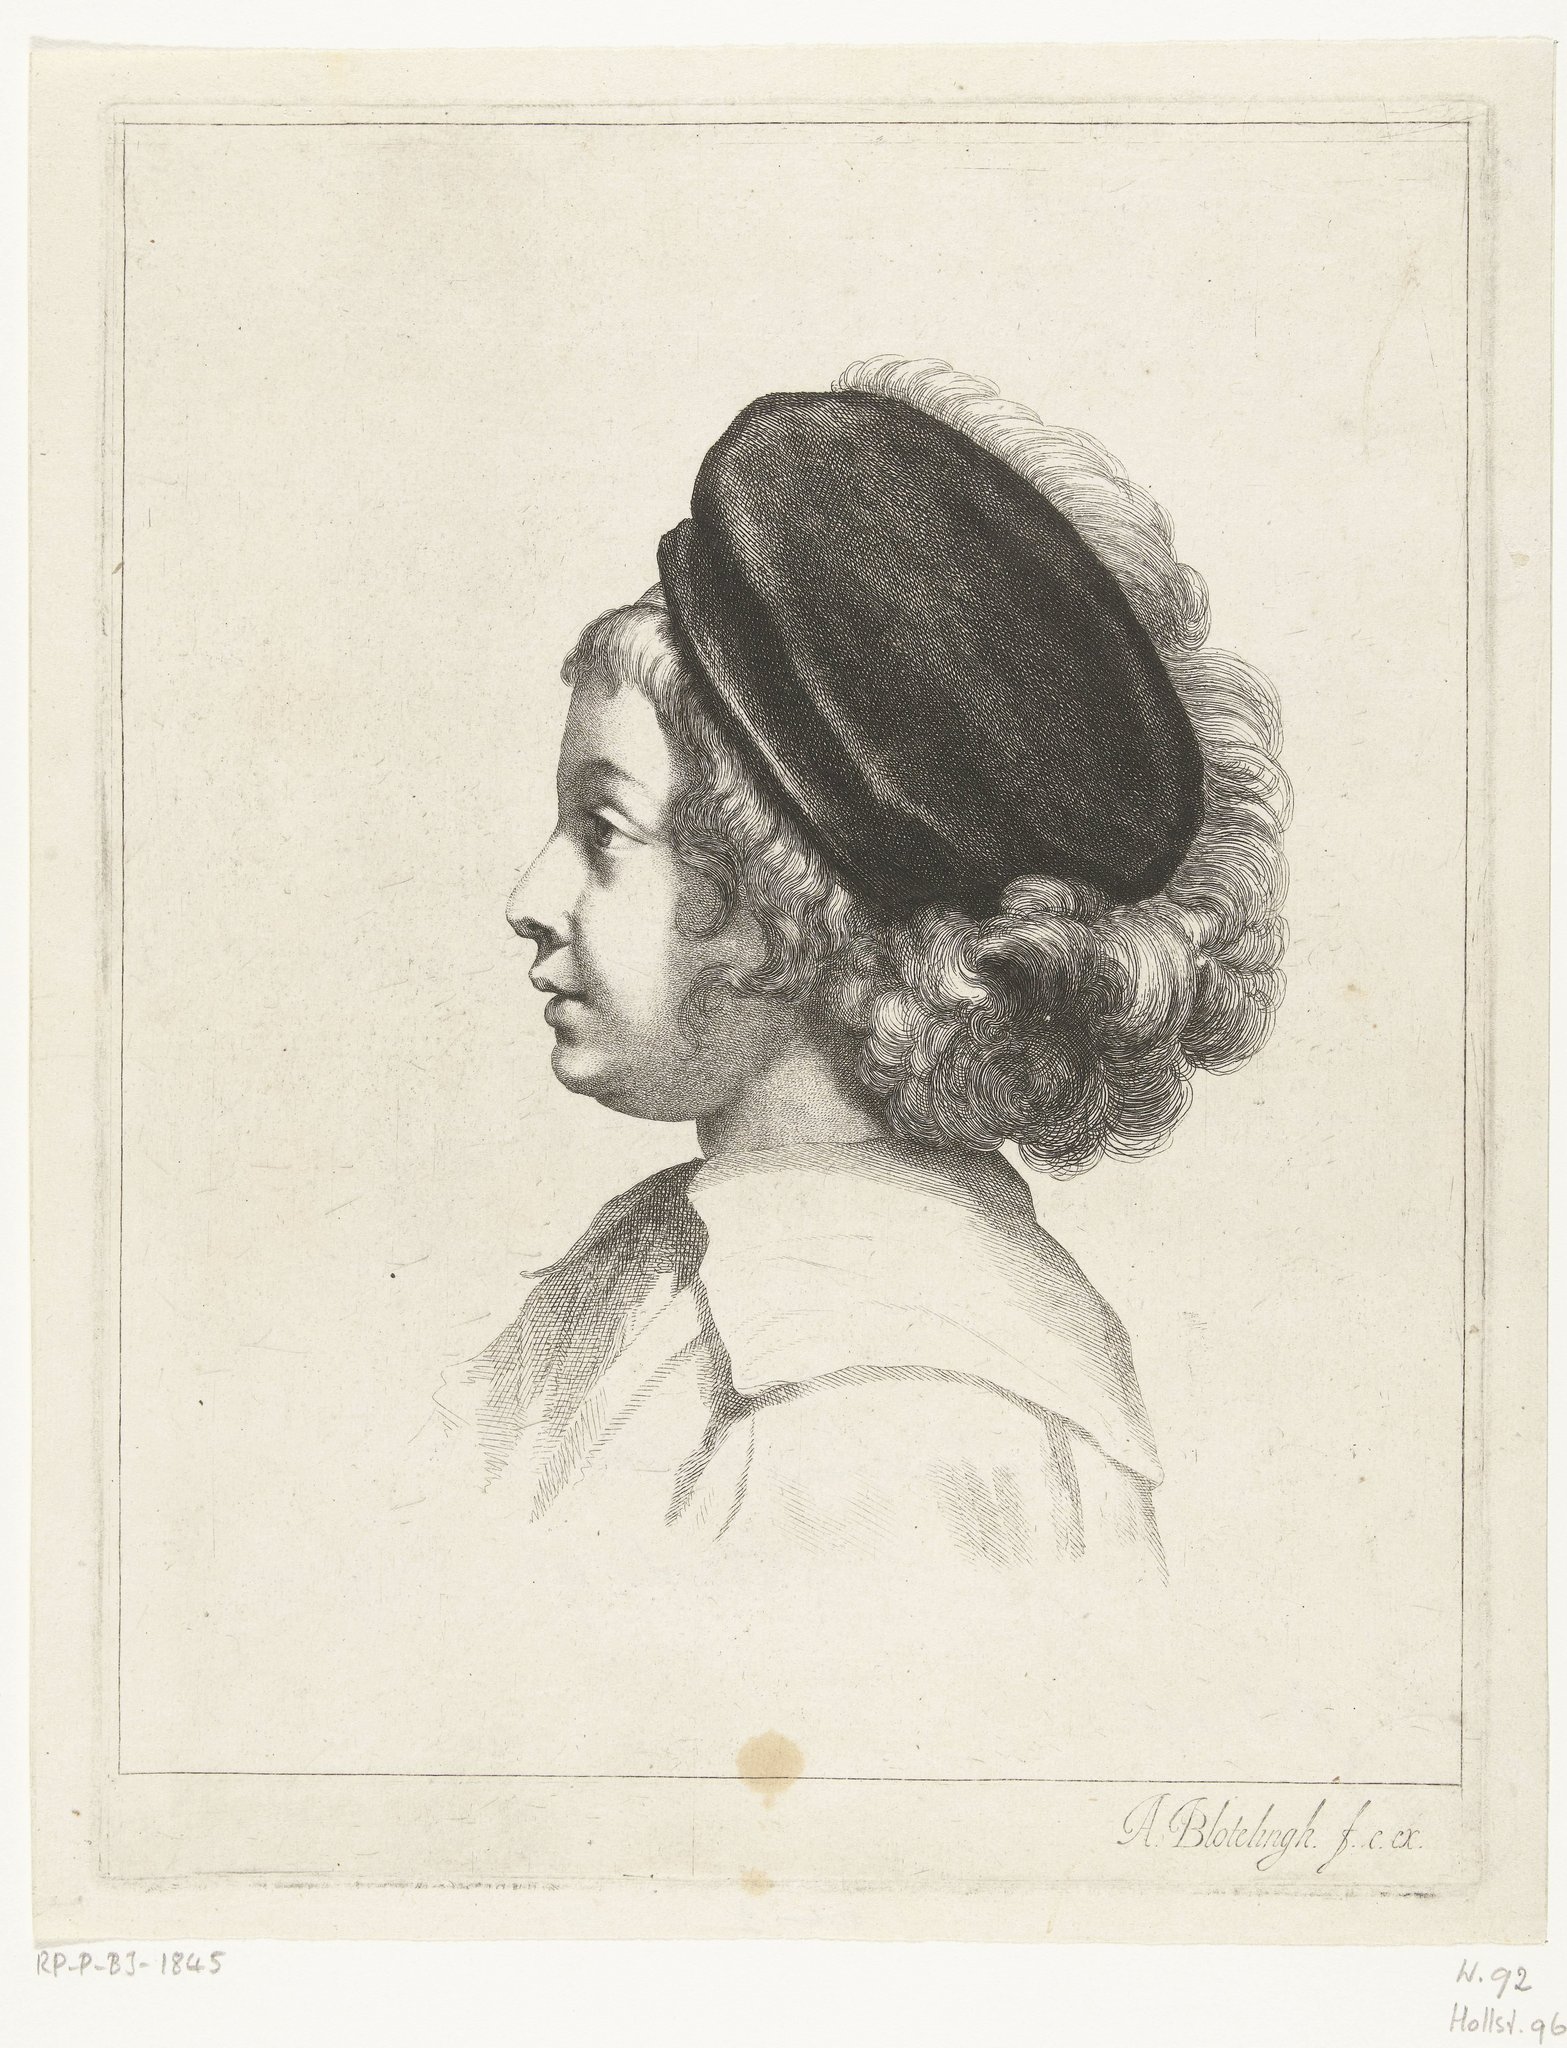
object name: print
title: Portretbuste van de zoon van Peter Paul Rubens, met zwarte pet op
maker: abraham bloteling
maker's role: draughtsman, print maker, publisher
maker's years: 1640-1690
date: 1655-1690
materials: paper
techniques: etching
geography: amsterdam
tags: boy (child between toddler and youth) (+ left side visible; left - (l. hand, l. foot, etc.))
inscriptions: collector's mark: Lugt 240